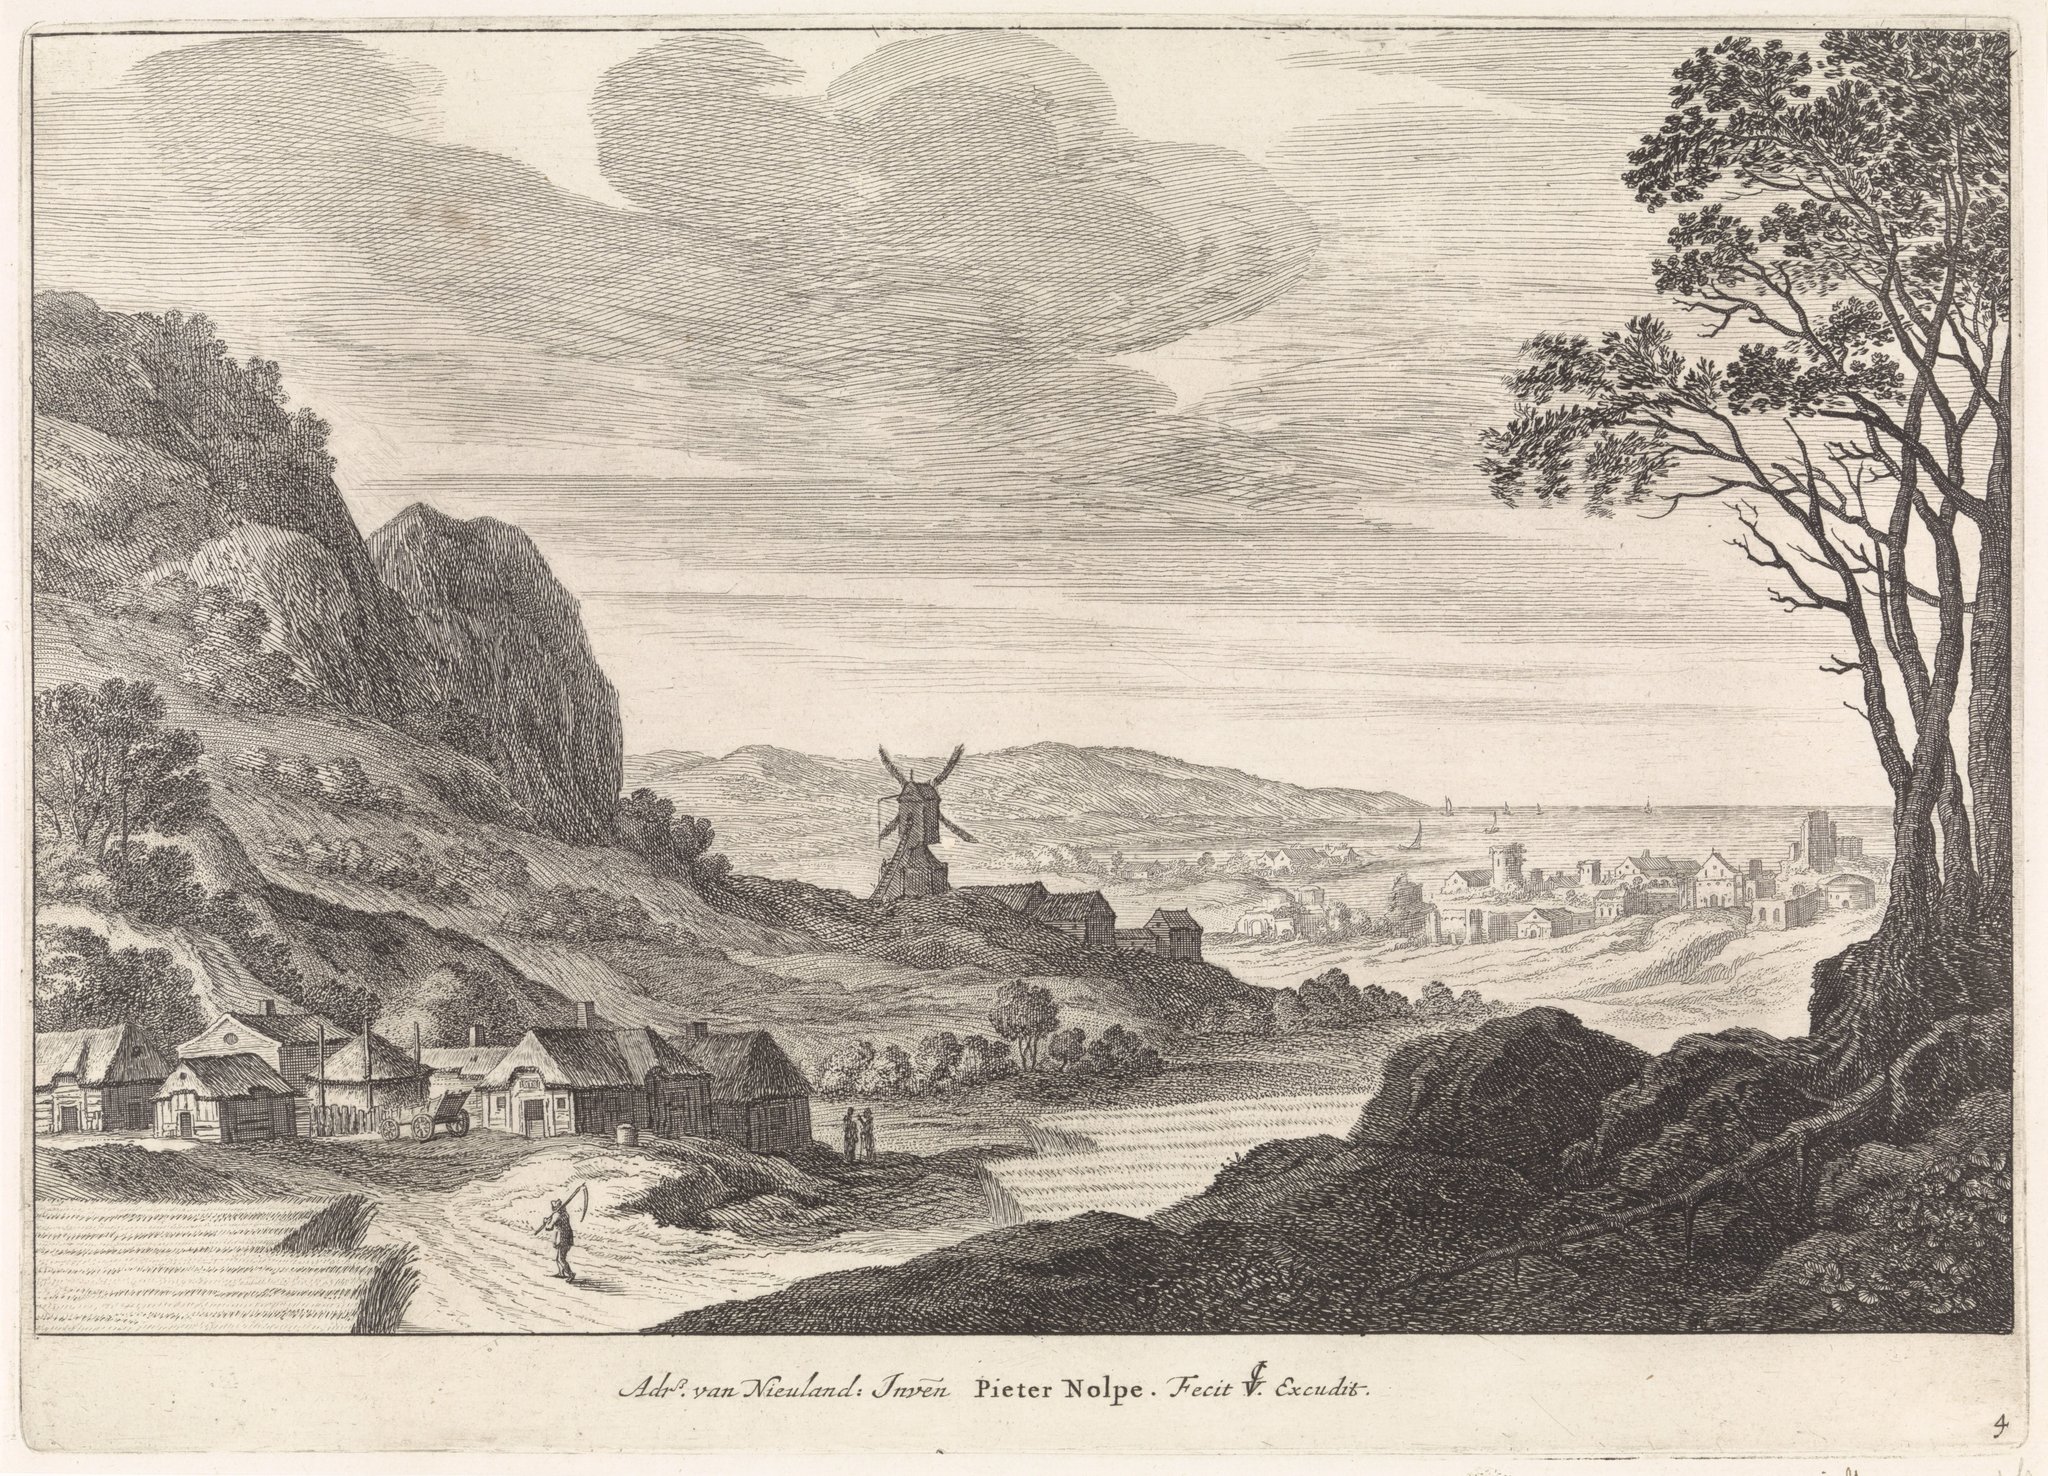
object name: print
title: Kustlandschap met een molen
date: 1623-1653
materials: paper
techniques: engraving, etching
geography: amsterdam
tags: cereal, grain, corn (grass with grains, grown for food, e.g.: wheat, rice, rye, oats, maize, buckwheat, millet), windmill, coast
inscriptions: collector's mark: Lugt 2228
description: Heuvelachtig landschap met graanvelden, een boerendorp en een molen. Rechtsachter een dorp aan zee. Prent uit een serie landschappen.